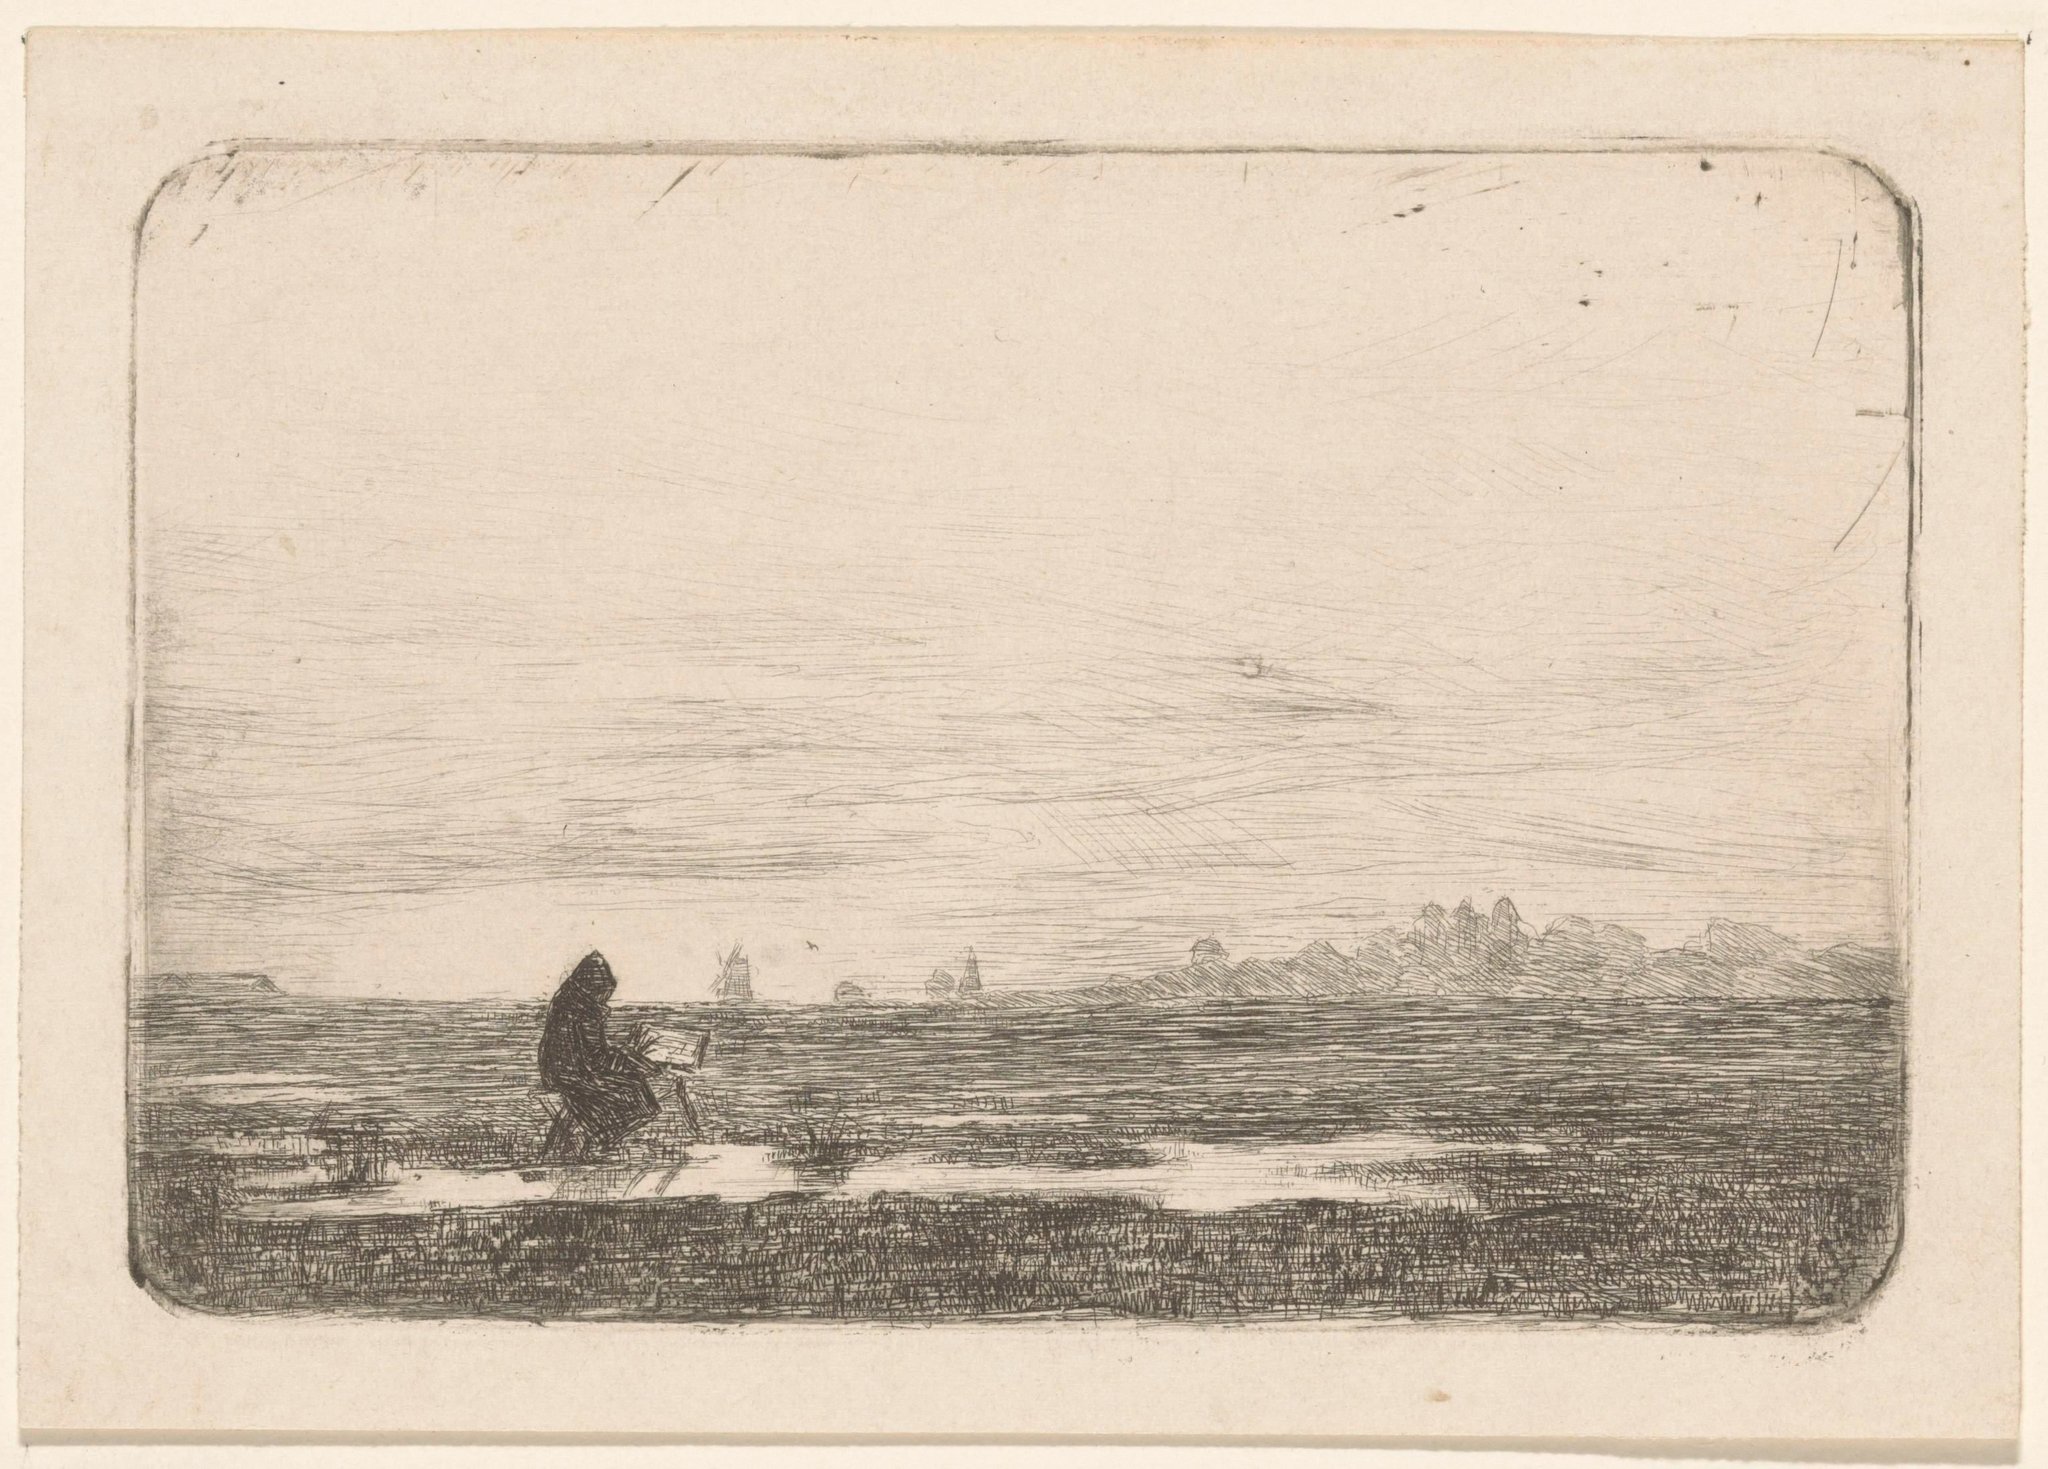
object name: print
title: De landschapsschilder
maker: floris arntzenius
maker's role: draughtsman, print maker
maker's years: 1864-1925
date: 1874-1887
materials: paper, ink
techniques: etching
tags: painter at work, in his studio - cc - out of doors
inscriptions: inscription: ‘staat I’, collector's mark: Lugt 2228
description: Polderlandschap met links een figuur achter een schildersezel, in de verte een molen en bomen.